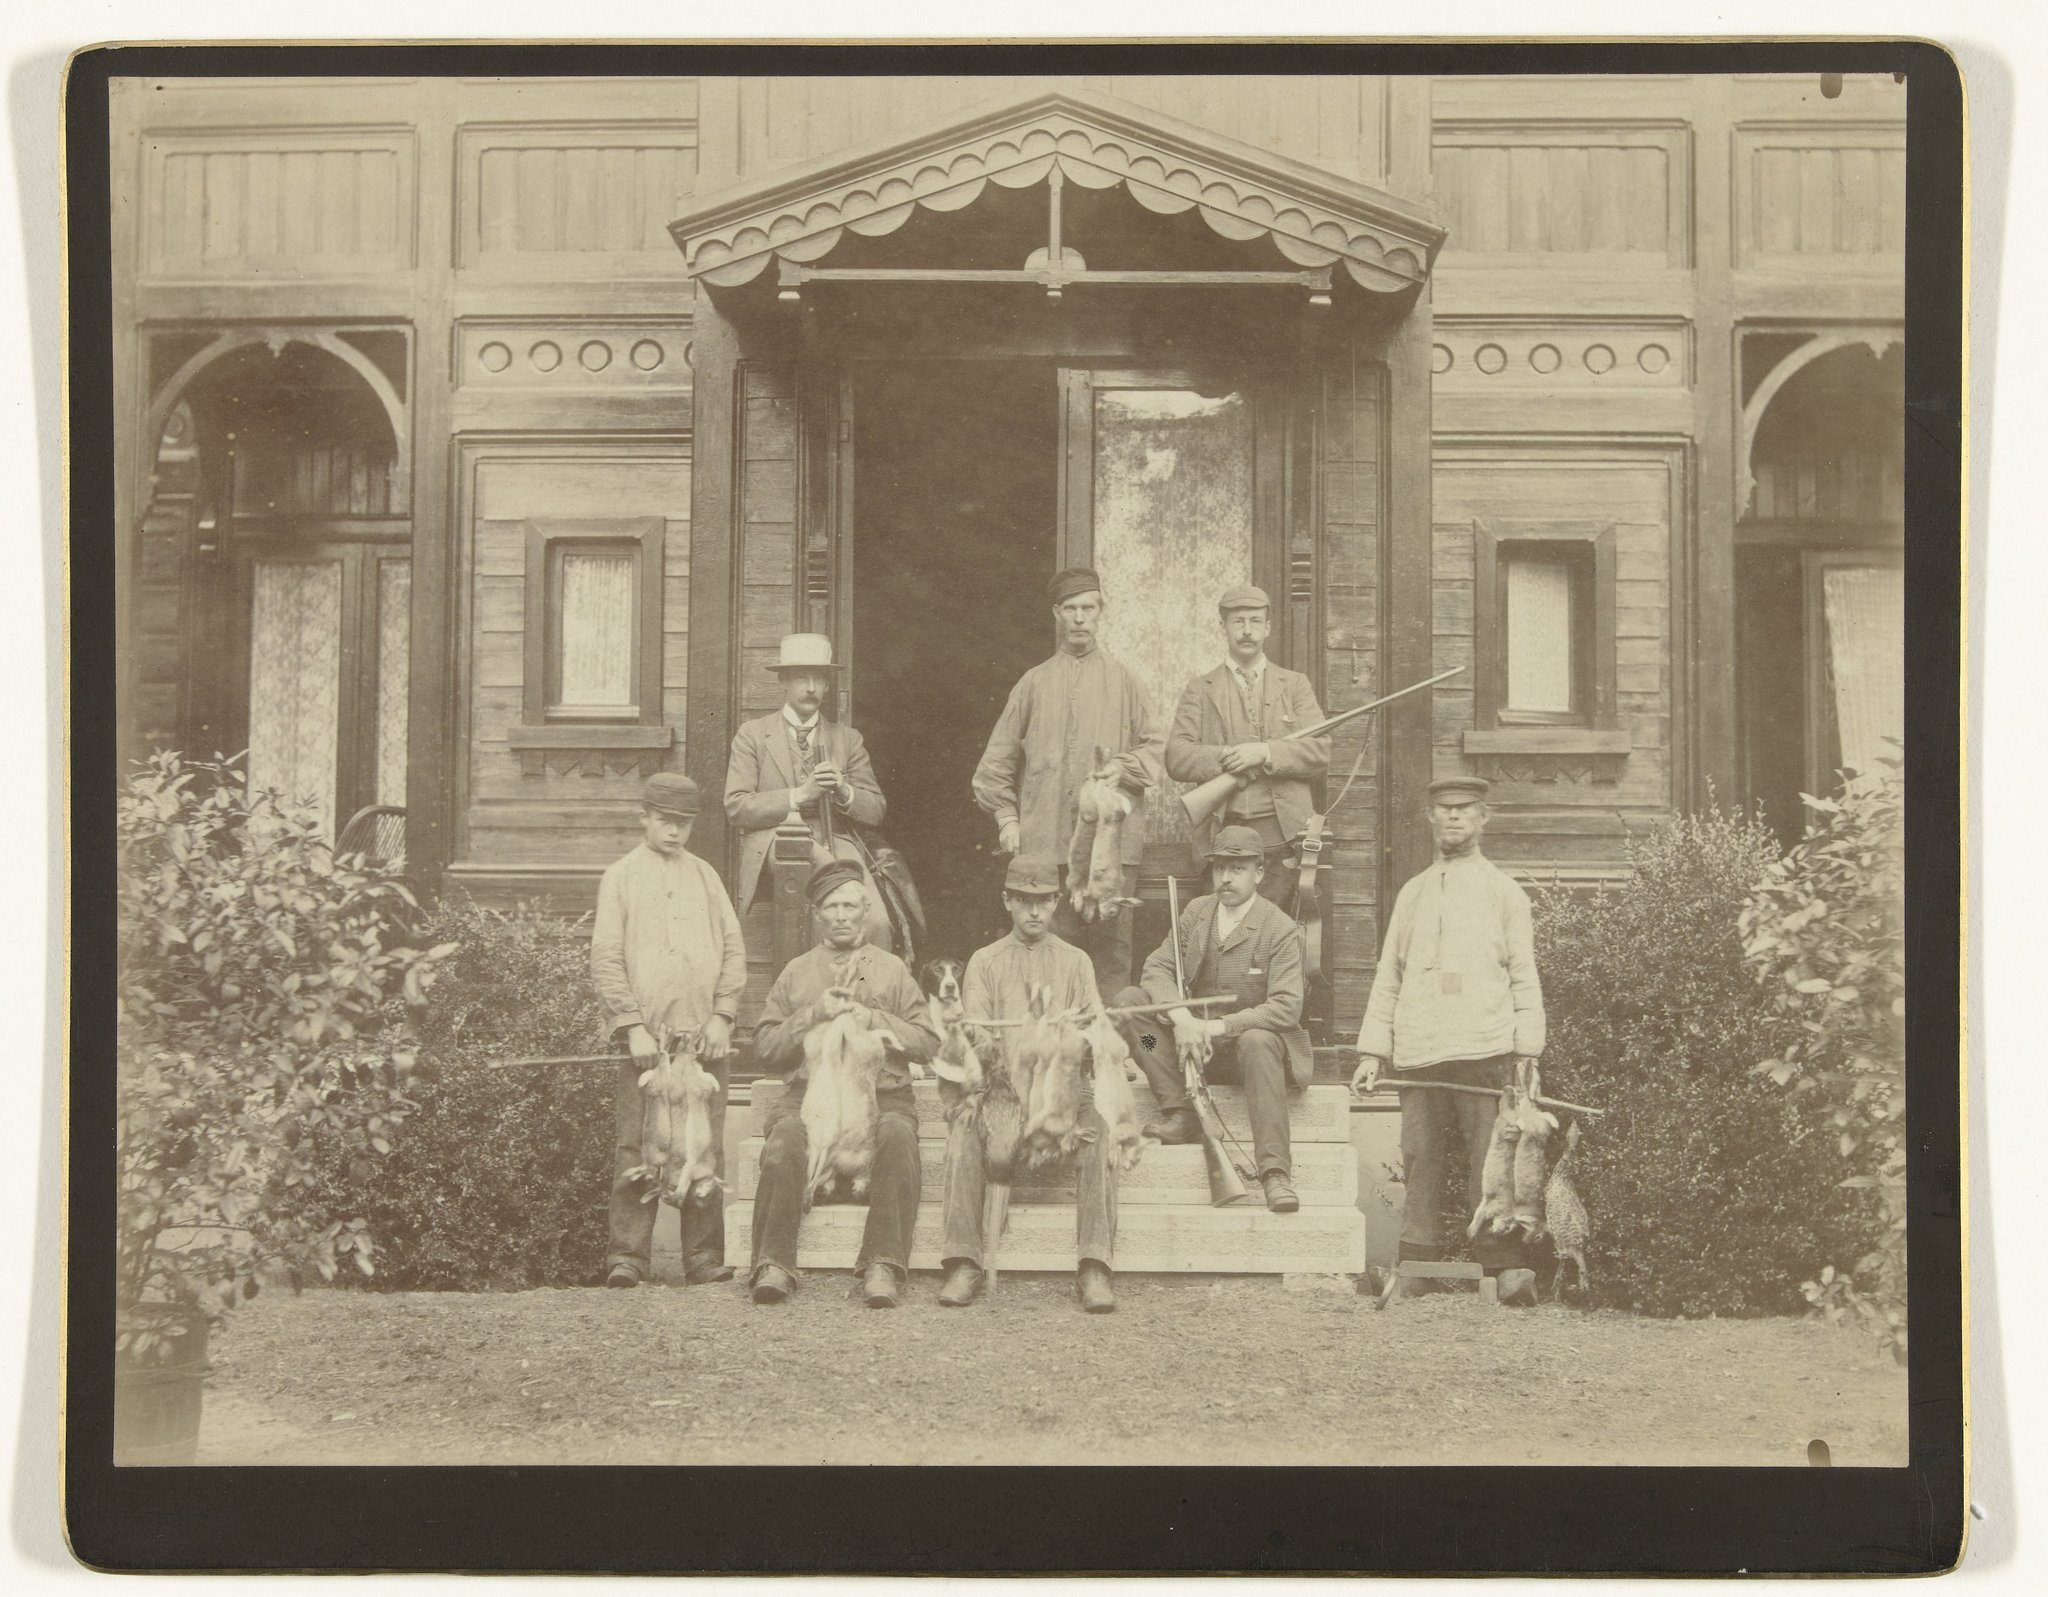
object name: photograph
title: Groepsportret van Maarten en Henry Pauw van Wieldrecht en drijvers, na afloop van de jacht poserend met geschoten wild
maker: henry pauw van wieldrecht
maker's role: fotograaf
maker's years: 1863-1912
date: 1891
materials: cardboard, photographic support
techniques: albumen print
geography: netherlands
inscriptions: annotation: ‘No 105. 450. 1891.’, annotation: ‘H. Pauw v. Wieldrecht / Maarten Pauw / v. Wieldrecht’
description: Links Maarten (met geweer en hoed), rechts Henri (met geweer, bril en pet).